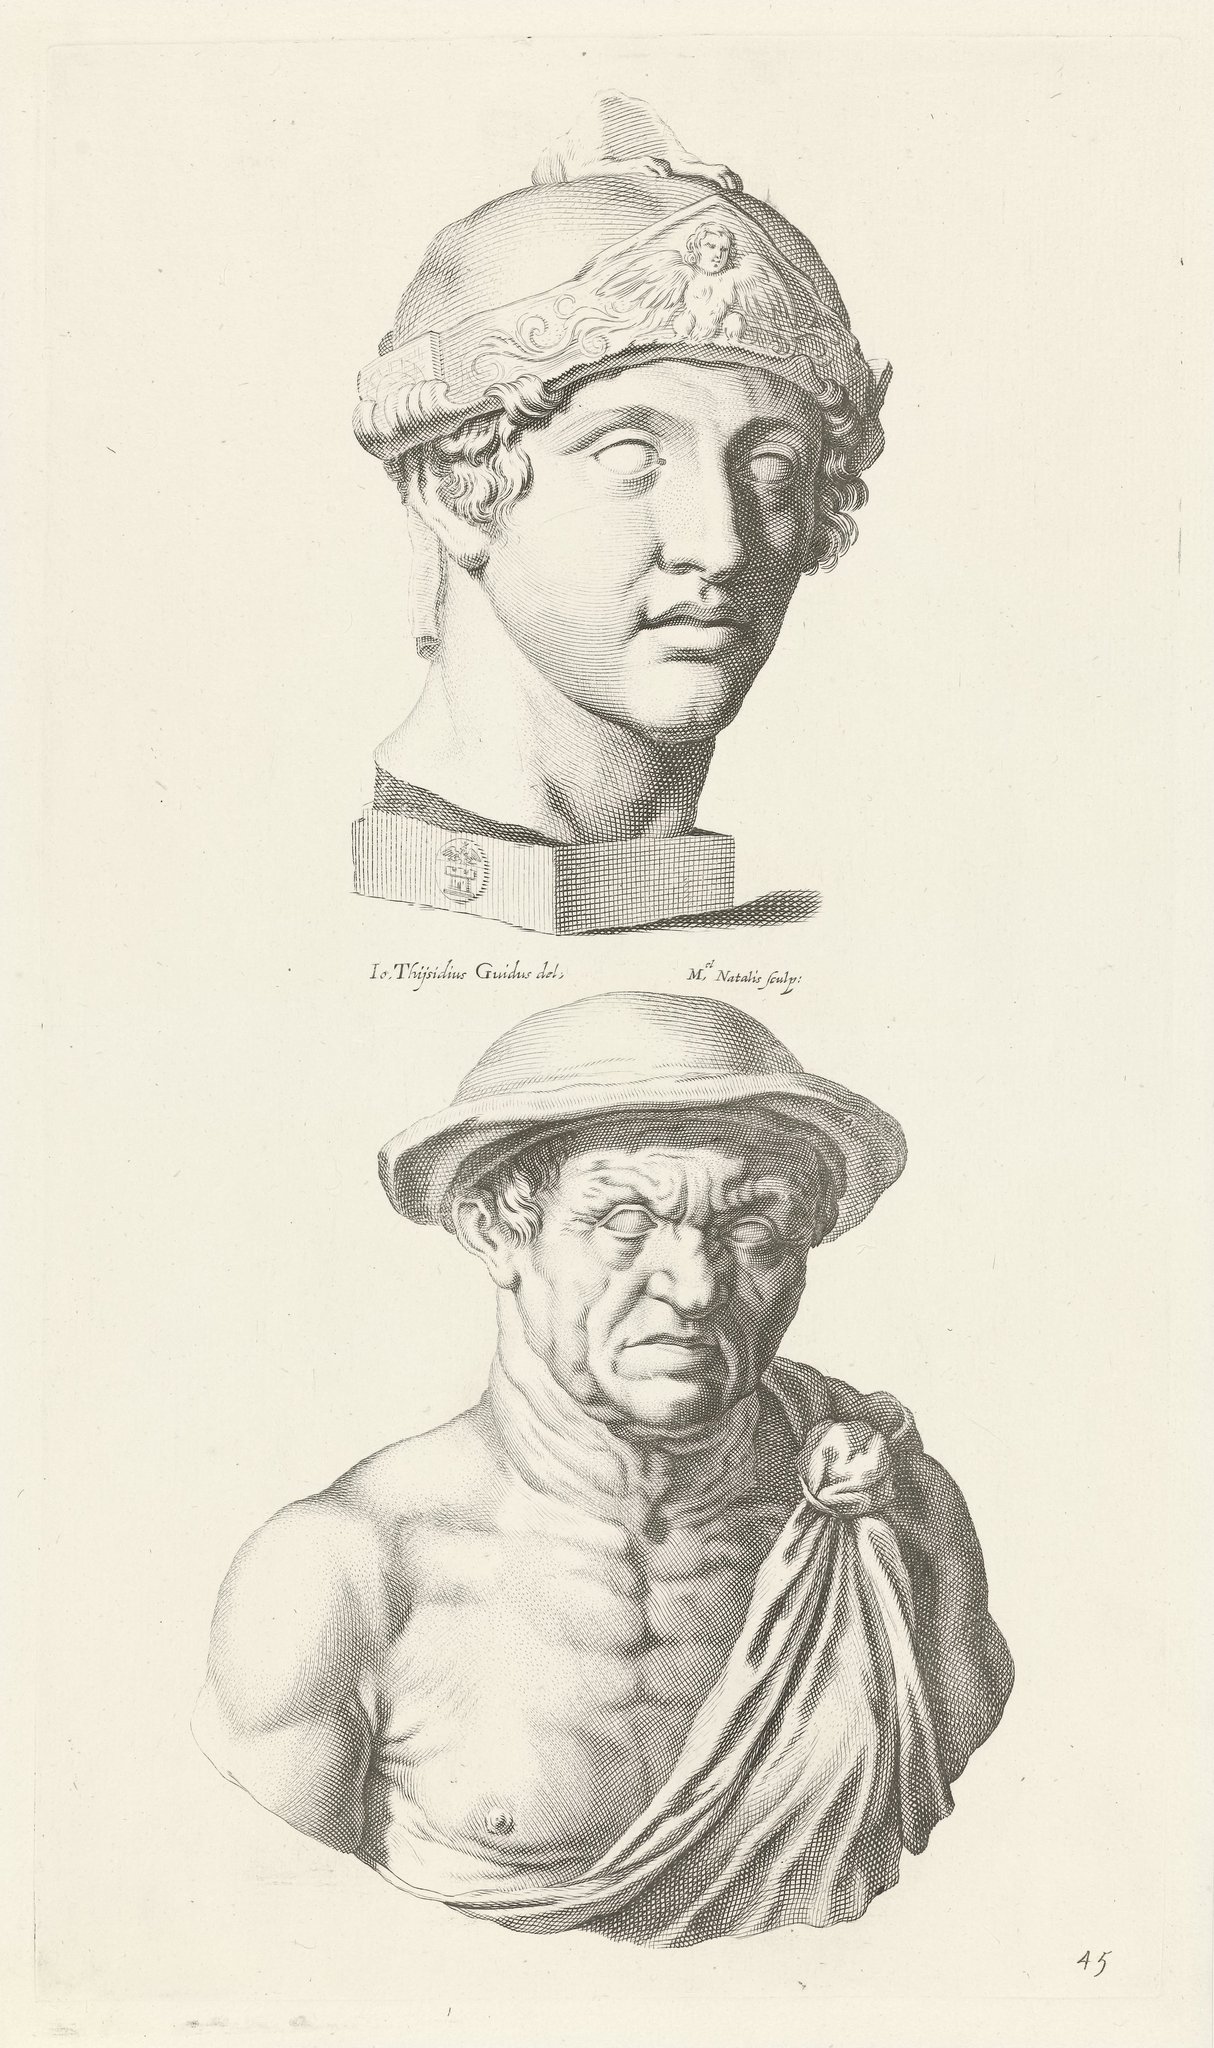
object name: print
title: Galleria Giustiniana del Marchese Vincenzo Giustiniani II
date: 1640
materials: paper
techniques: engraving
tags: rome, vincenzo giustiniani (1564-1637), male persons from classical history (+ head, bust, etc.), piece of sculpture, reproduction of a piece of sculpture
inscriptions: collector's mark: Lugt 2228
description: Twee Romeinse sculpturen. Boven het portret van een gladiator, met helm op het hoofd. In het midden van de helm is een gevleugelde man afgebeeld. Op de basis van het beeld het wapenschild van Vincenzo Giustiniani. Onder de buste van een oude man met hoed, de borst deels ontbloot, een kleed over één schouder. Prent uit een serie naar de sculpturen in de verzameling in de Galleria Giustiniani te Rome.